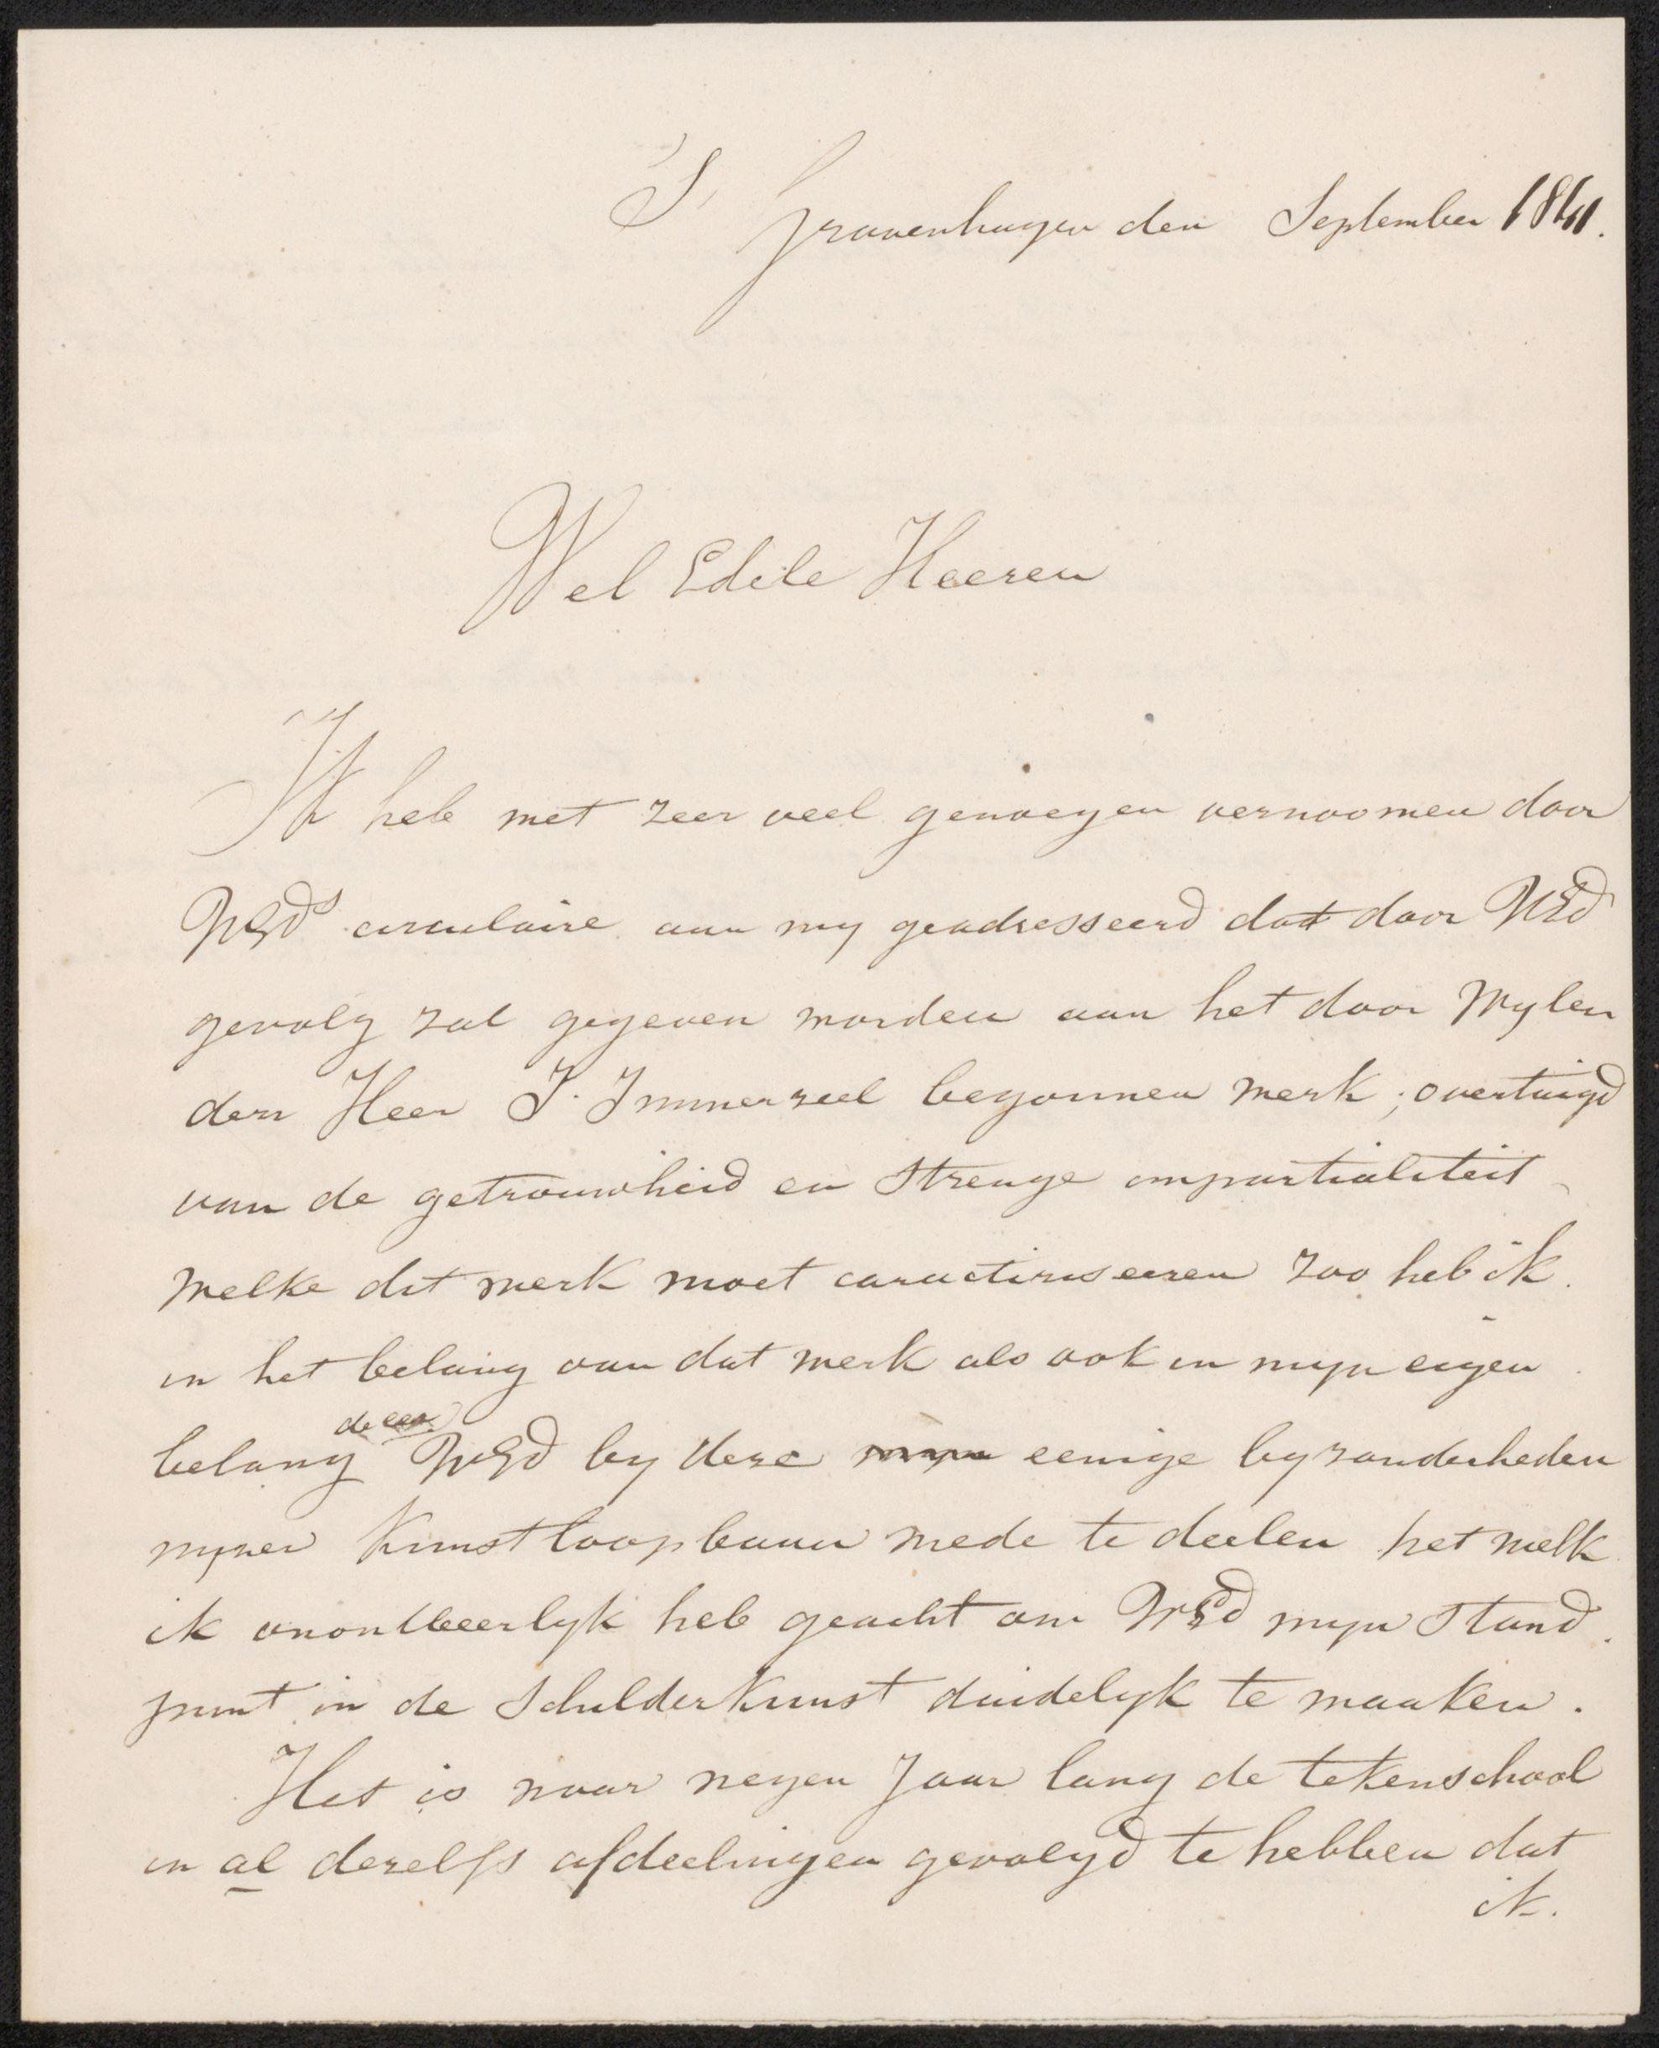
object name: letter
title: Brief aan Christiaan Immerzeel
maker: willem george wagner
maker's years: 1814-1855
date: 1809-1841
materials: ink, paper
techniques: pen, writing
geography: the hague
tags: publisher, johannes immerzeel, print maker, christiaan immerzeel, education, tuition of the artist (in general), painting (including book-illumination, miniature-painting)